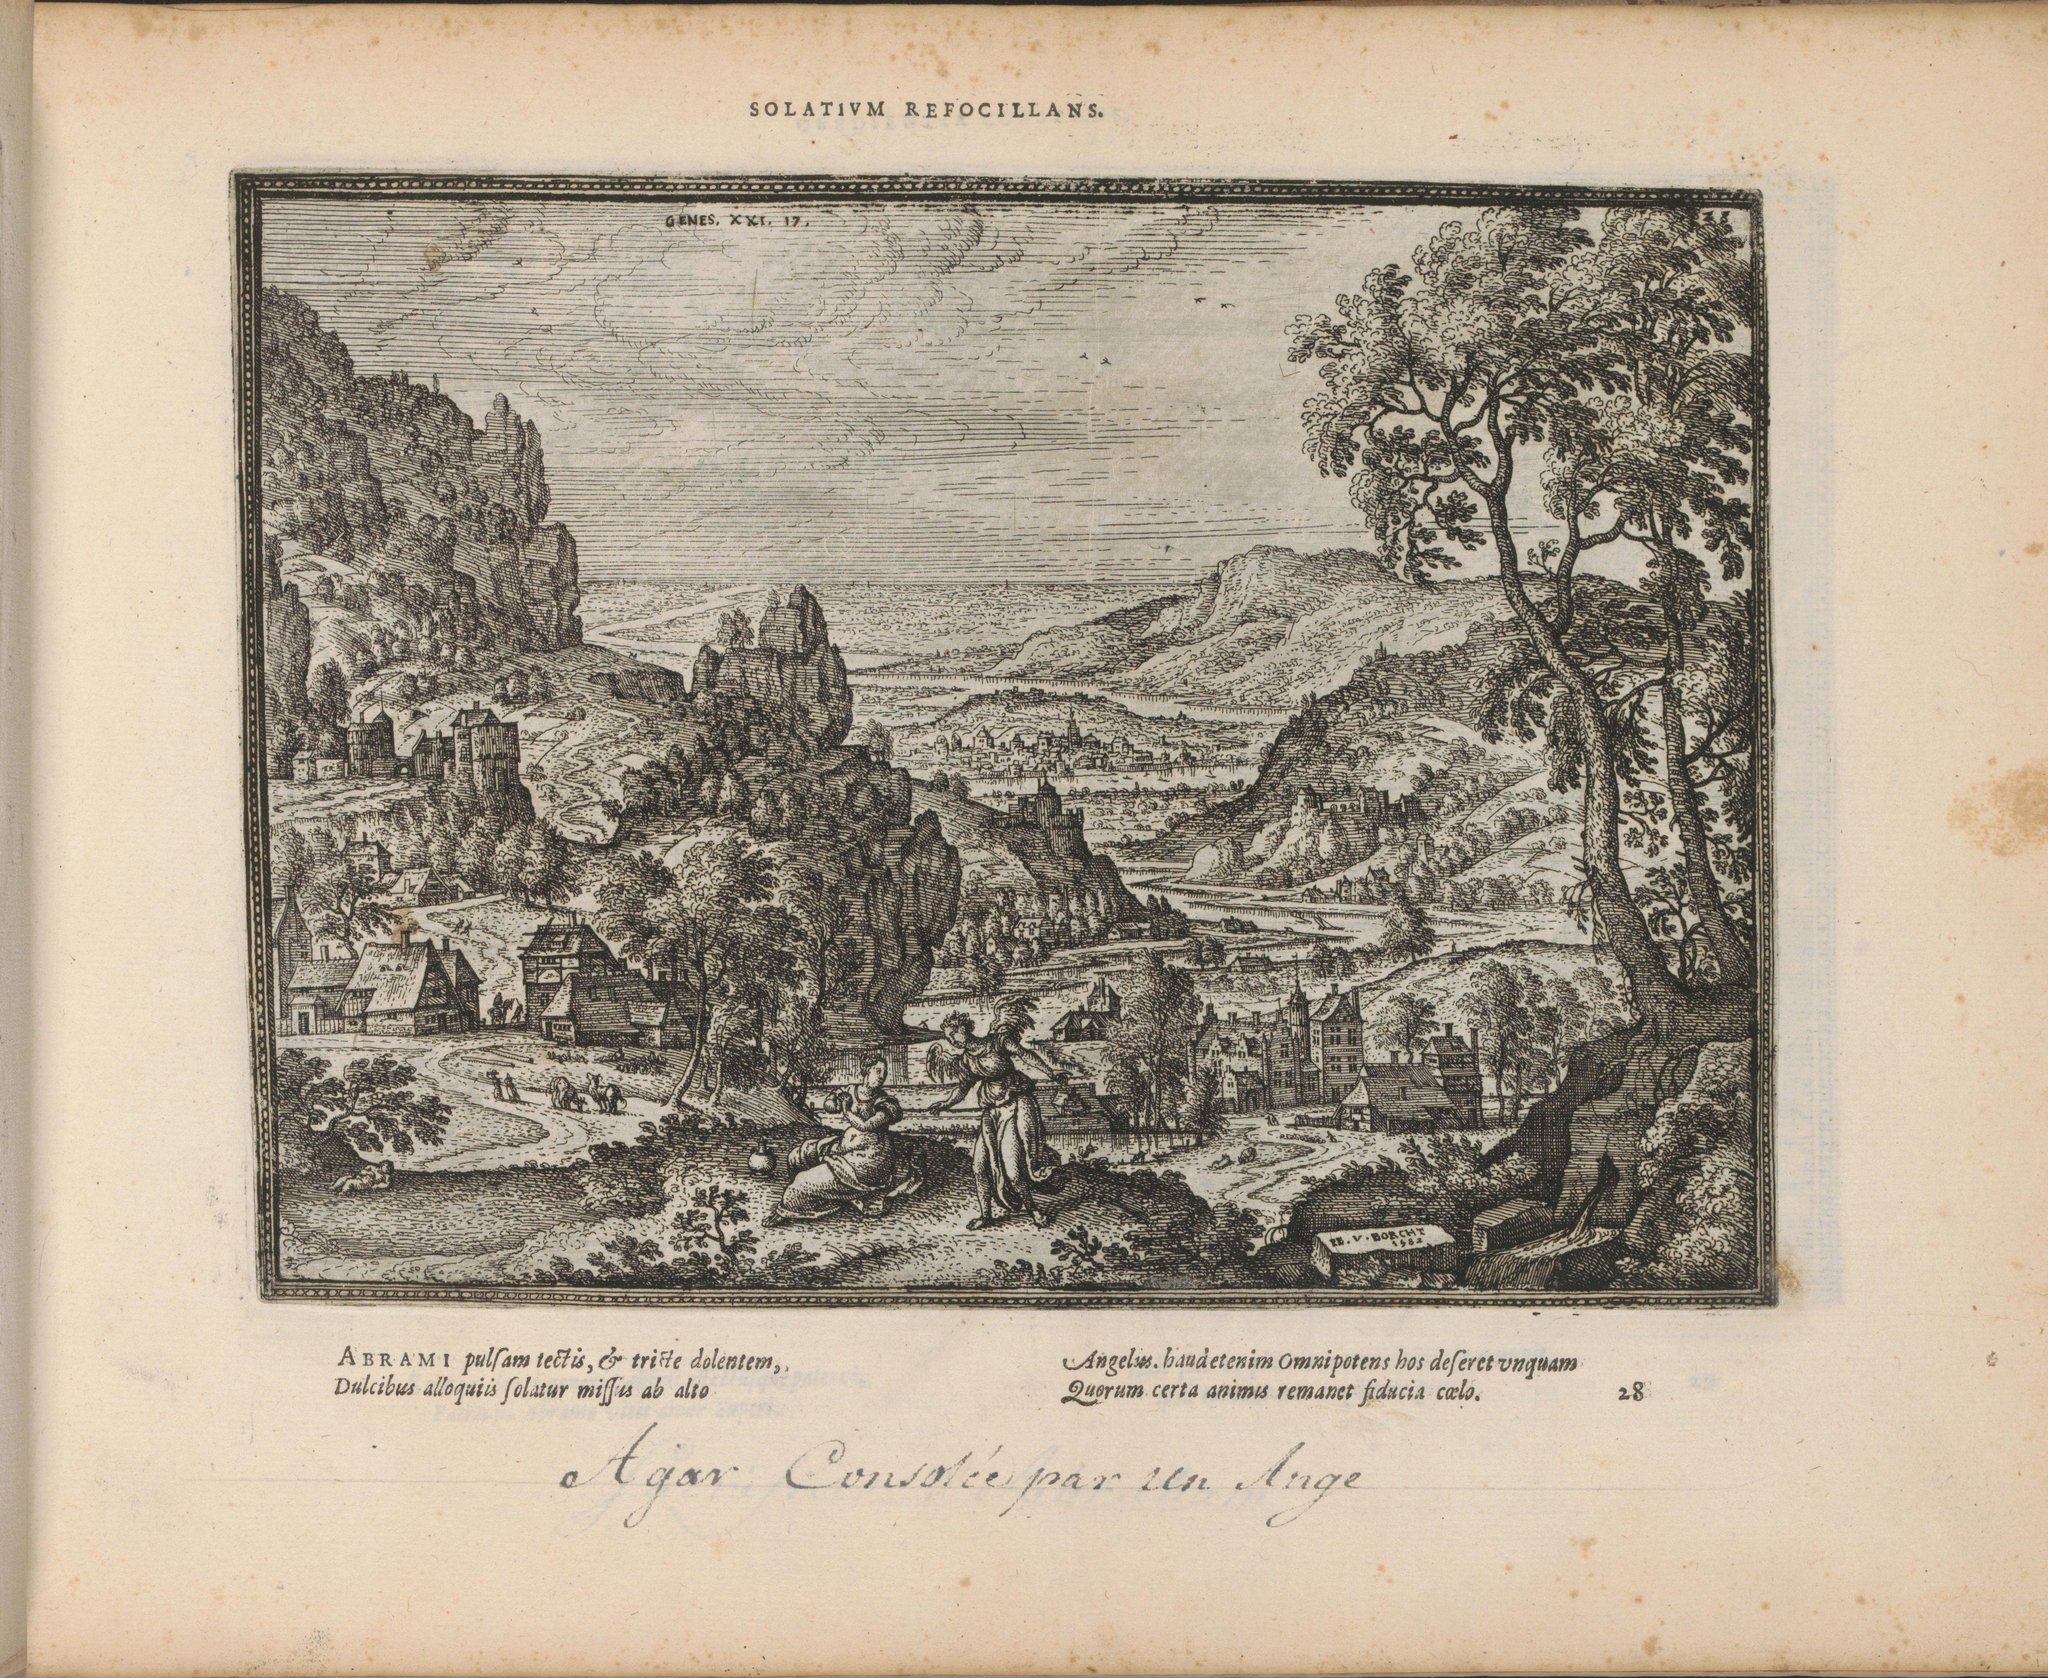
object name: print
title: Landschap met Hagar en de engel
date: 1582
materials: paper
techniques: etching, letterpress printing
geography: amsterdam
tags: city-view, and landscape with man-made constructions, landscapes, river, hagar and ishmael in the wilderness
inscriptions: inscription: ‘Agar consulée par un Ange’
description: Landschap met in het midden Hagar, de tweede vrouw van Abraham. Linksonder ligt haar kind Ismaël die zij bij gebrek aan water achterliet onder een struik. Een engel wijst Hagar op een waterbron achter haar (Gen. 21:17). Met een motto in het Latijn boven de voorstelling en een vierregelig onderschrift in het Latijn onder de prent. De prent maakt deel uit van een album.